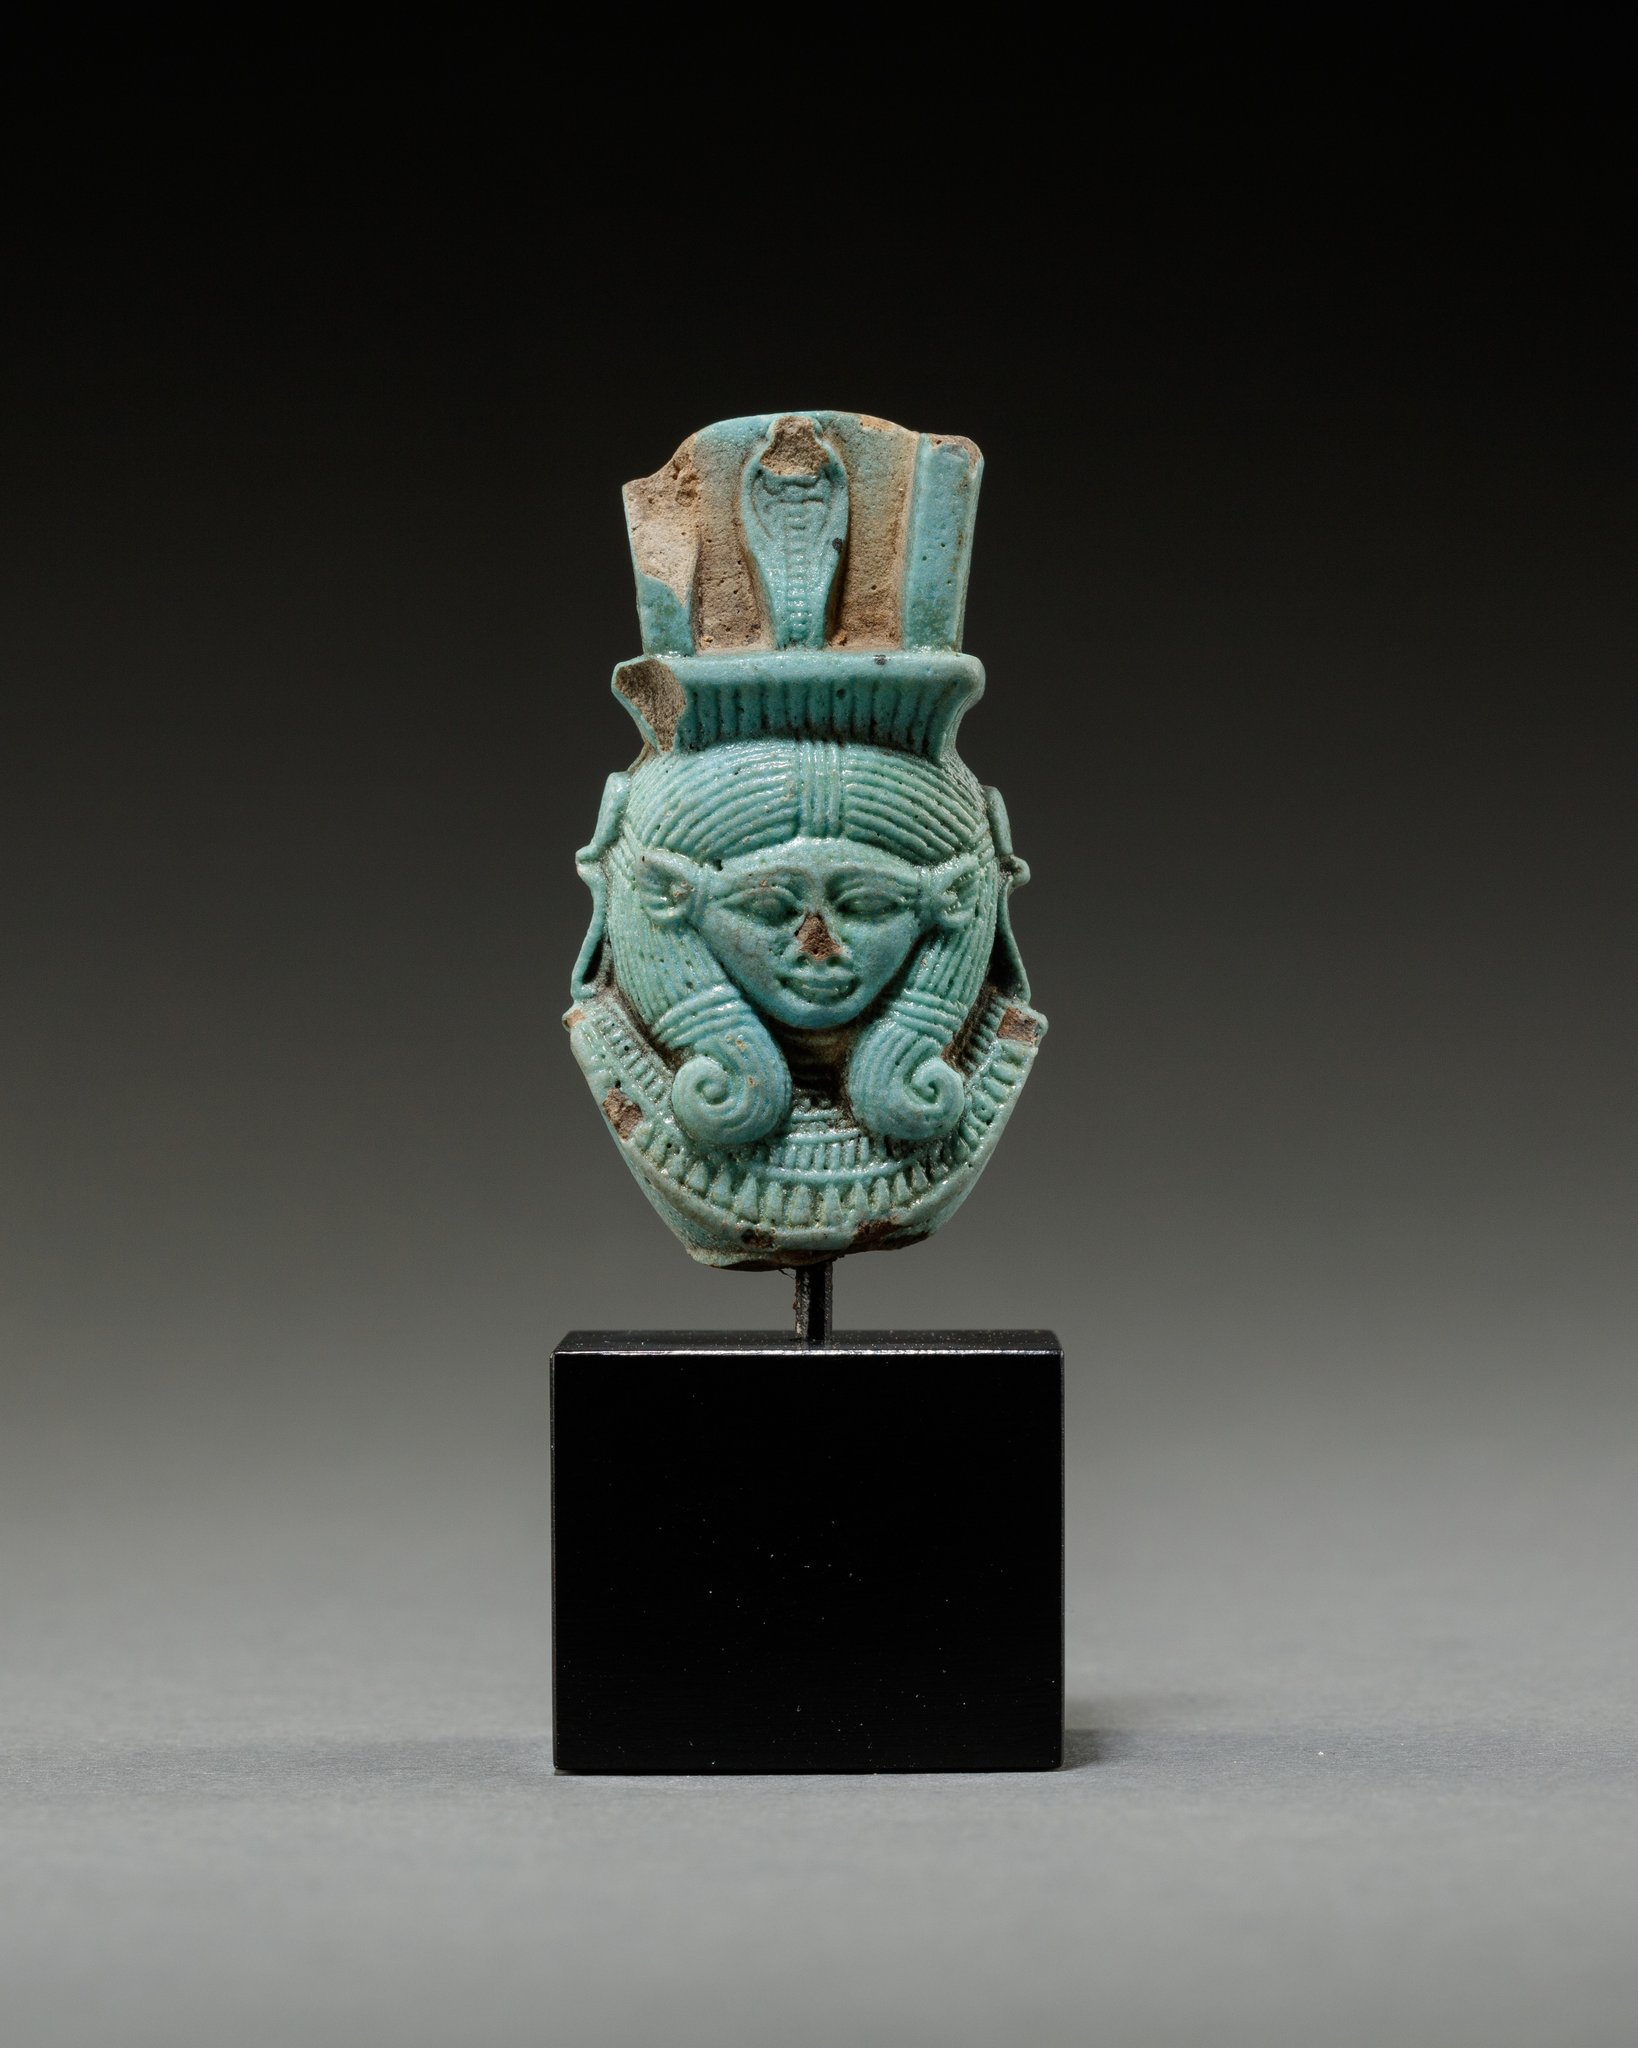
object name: part of a sistrum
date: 664-630 BCE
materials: faience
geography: egypt